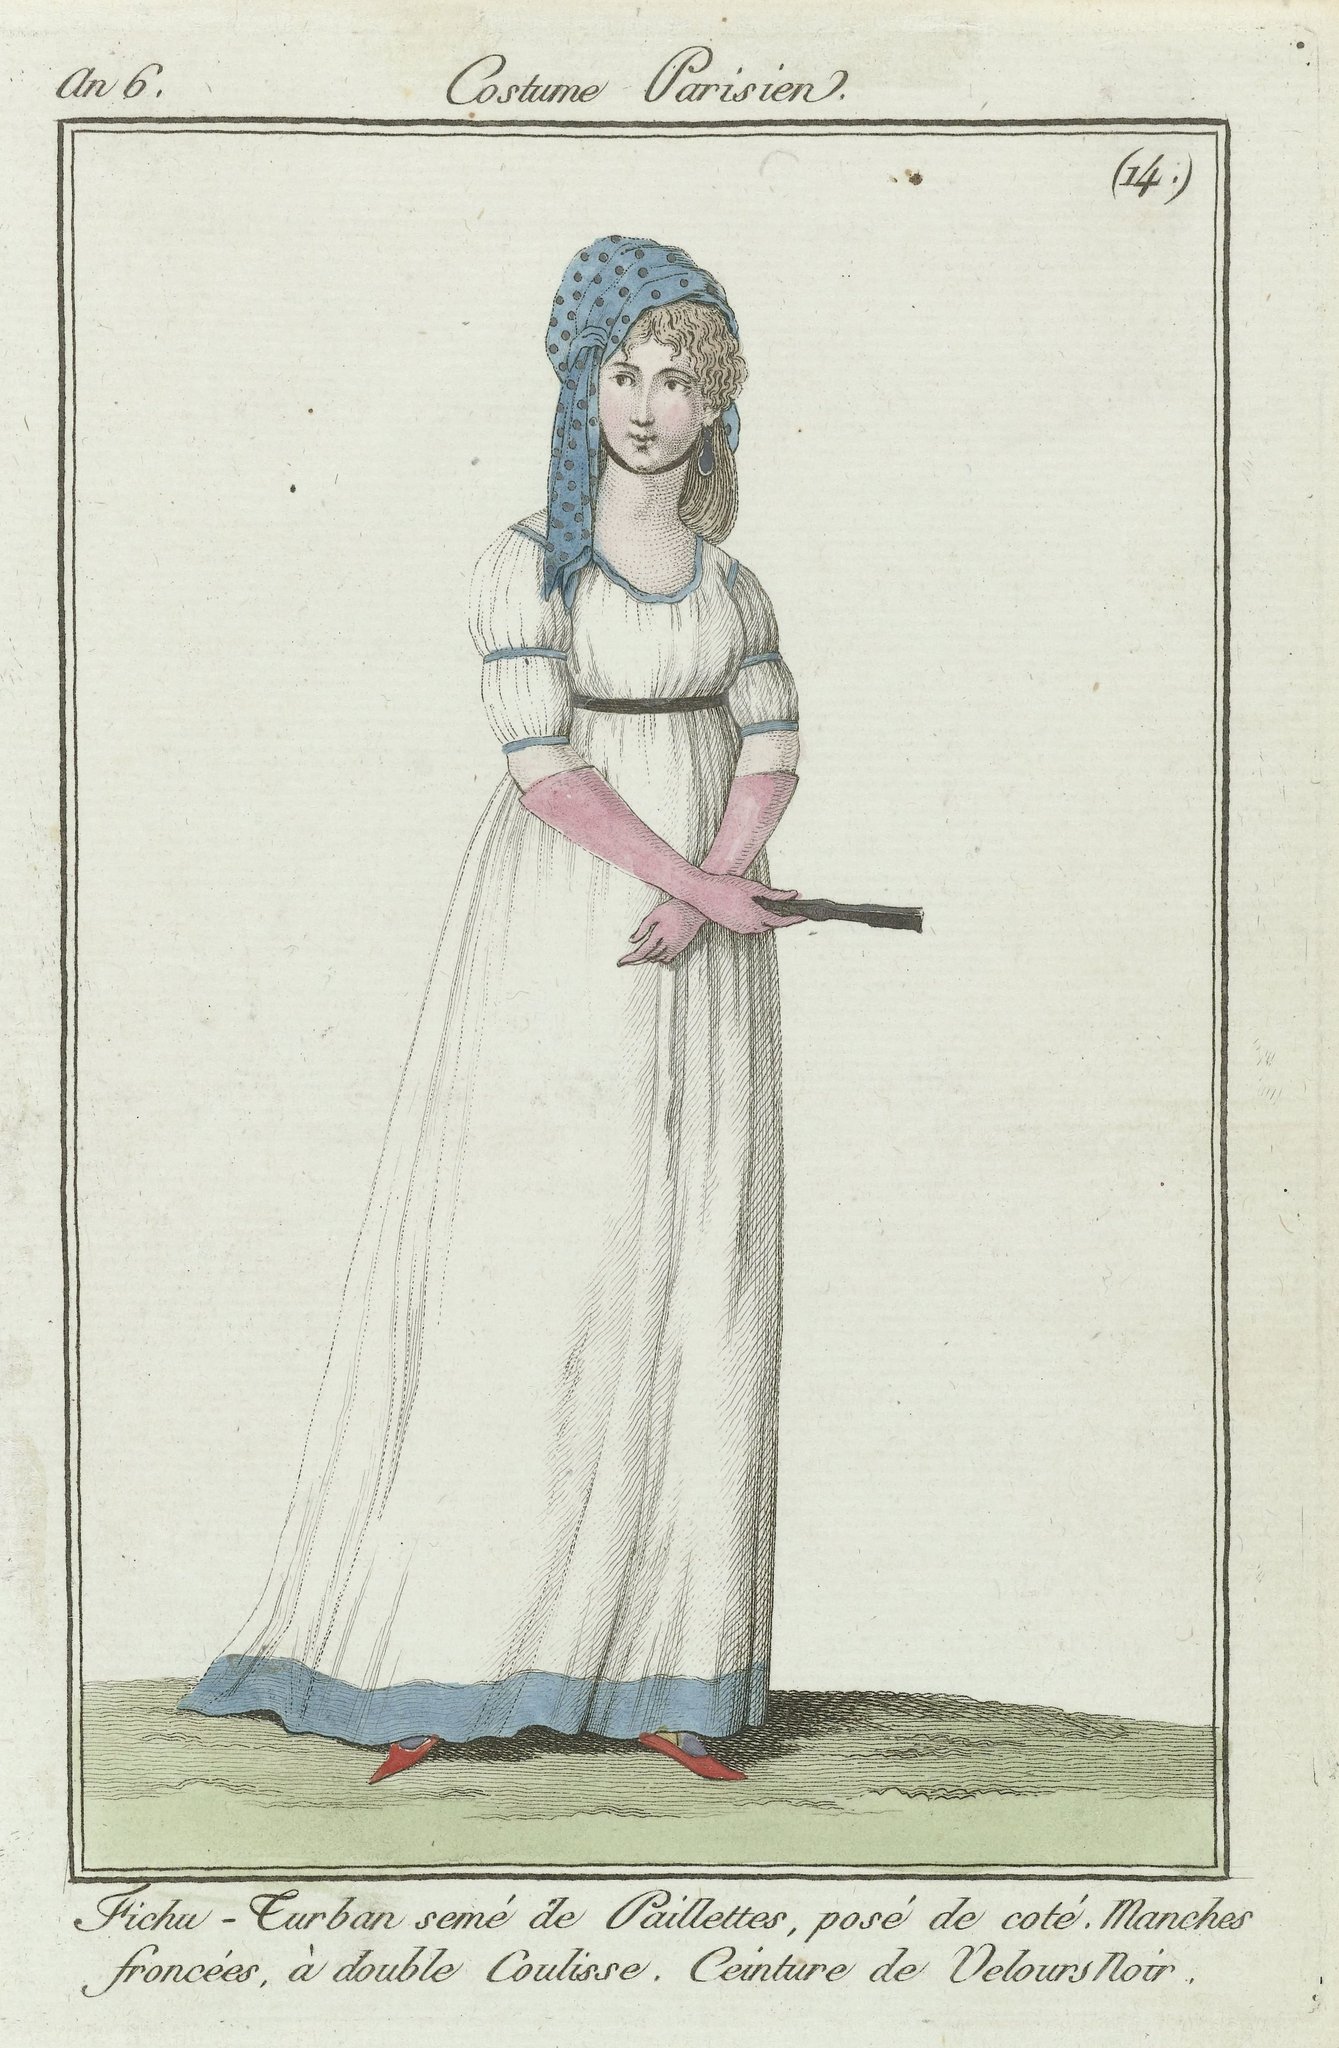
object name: fashion print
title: Journal des Dames et des Modes, Costume Parisien, 10 avril 1798, An 6, (14) : Fichu- Turban semé (...)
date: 1798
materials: paper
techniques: engraving, hand coloring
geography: paris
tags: head-gear: turban (+ women's clothes), gloves, mittens (long gloves) (+ women's clothes), border, ribbon, braid (+ women's clothes), fashion plates, shoes, sandals (+ women's clothes), dress, gown (+ women's clothes), fan (+ women's clothes), piece of clothing covering the breast or décolleté (fichu) (+ women's clothes), sleeves (+ women's clothes), belt, girdle, waistband (+ women's clothes)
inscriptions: title: ‘Costume Parisien.’, caption: ‘Fichu- Turban semé de Paillettes, posé de coté. Manches froncées, à double Coulisse. Ceinture de Velours Noir.’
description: Staande vrouw met schuin op het hoofd een fichu-tulband, bezaaid met pailletten. Zij draagt een japon met gesmokte mouwen. Ceintuur van zwart fluweel. Verdere accessoires: oorbel in het linkeroor, lange handschoenen, waaier, platte schoenen met puntige neuzen. De prent maakt deel uit van het modetijdschrift Journal des Dames et des Modes, uitgegeven door Sellèque, Parijs, 1797-1839.